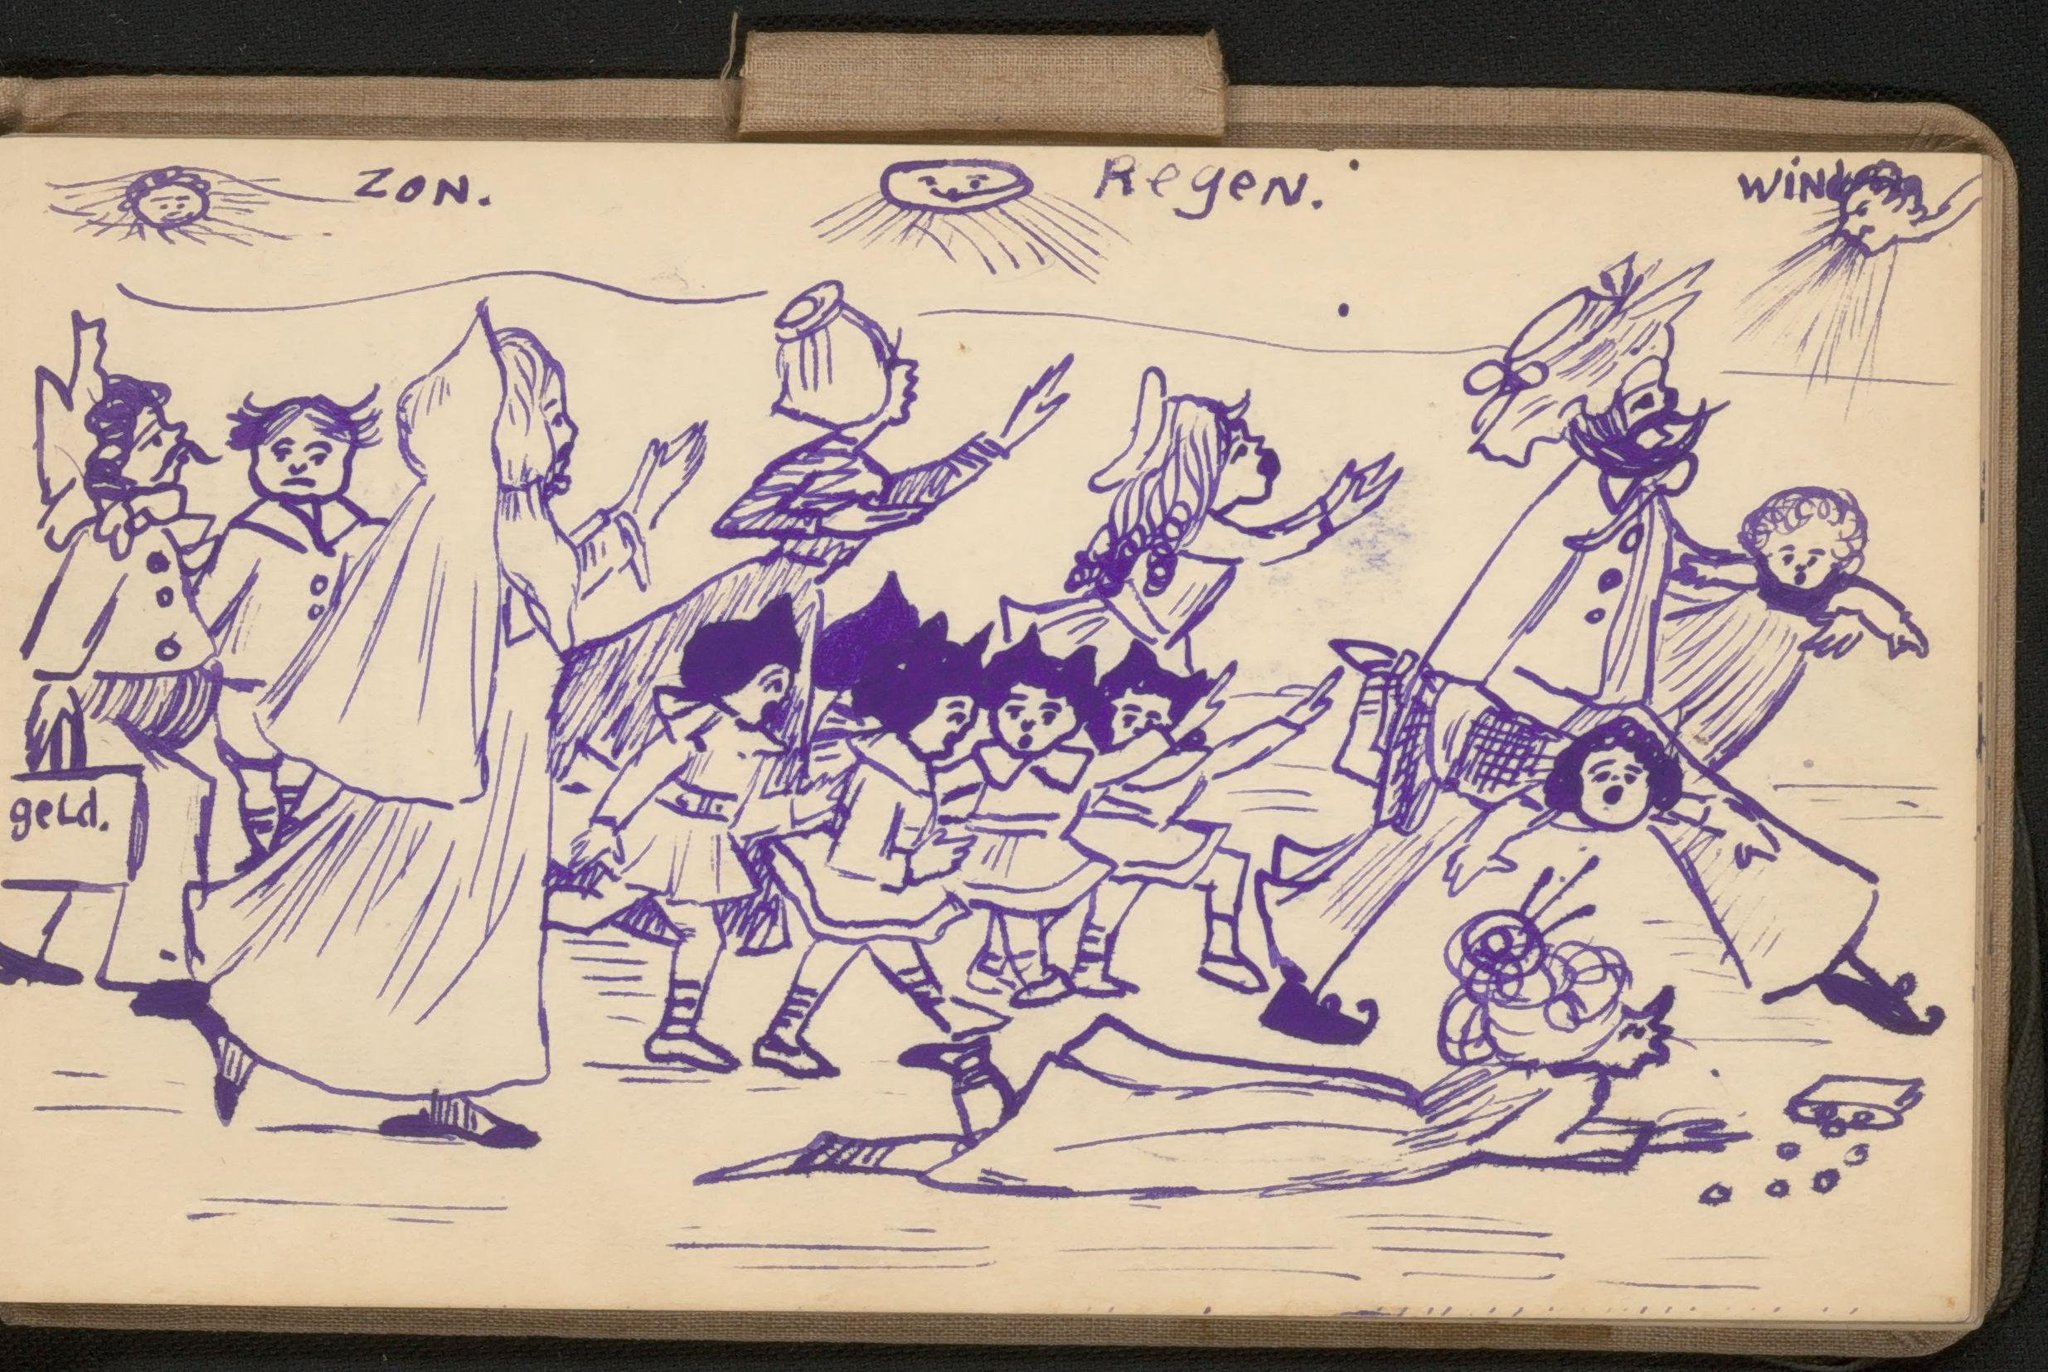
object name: sketchbook leaf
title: De familie op de vlucht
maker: Anonymous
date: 1875-1920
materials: ink, paper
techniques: pen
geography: netherlands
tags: on fire, ablaze, family life at home, living-room, parlour, sitting-room, breaking something (household accident)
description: De familie verlaat in paniek het huis na de brand in de huiskamer na met omvallen van de lamp. Onderdeel van het schetsboek met humoristische tekeningen over het leven van een 'famille nombreuse'. Onderwerpsrubrieken binnen de Atlas Zeden en Gewoonten: Zeden en Gewoonten in Engeren Zin, Des menschen beging, midden en einde, Kinderleven.